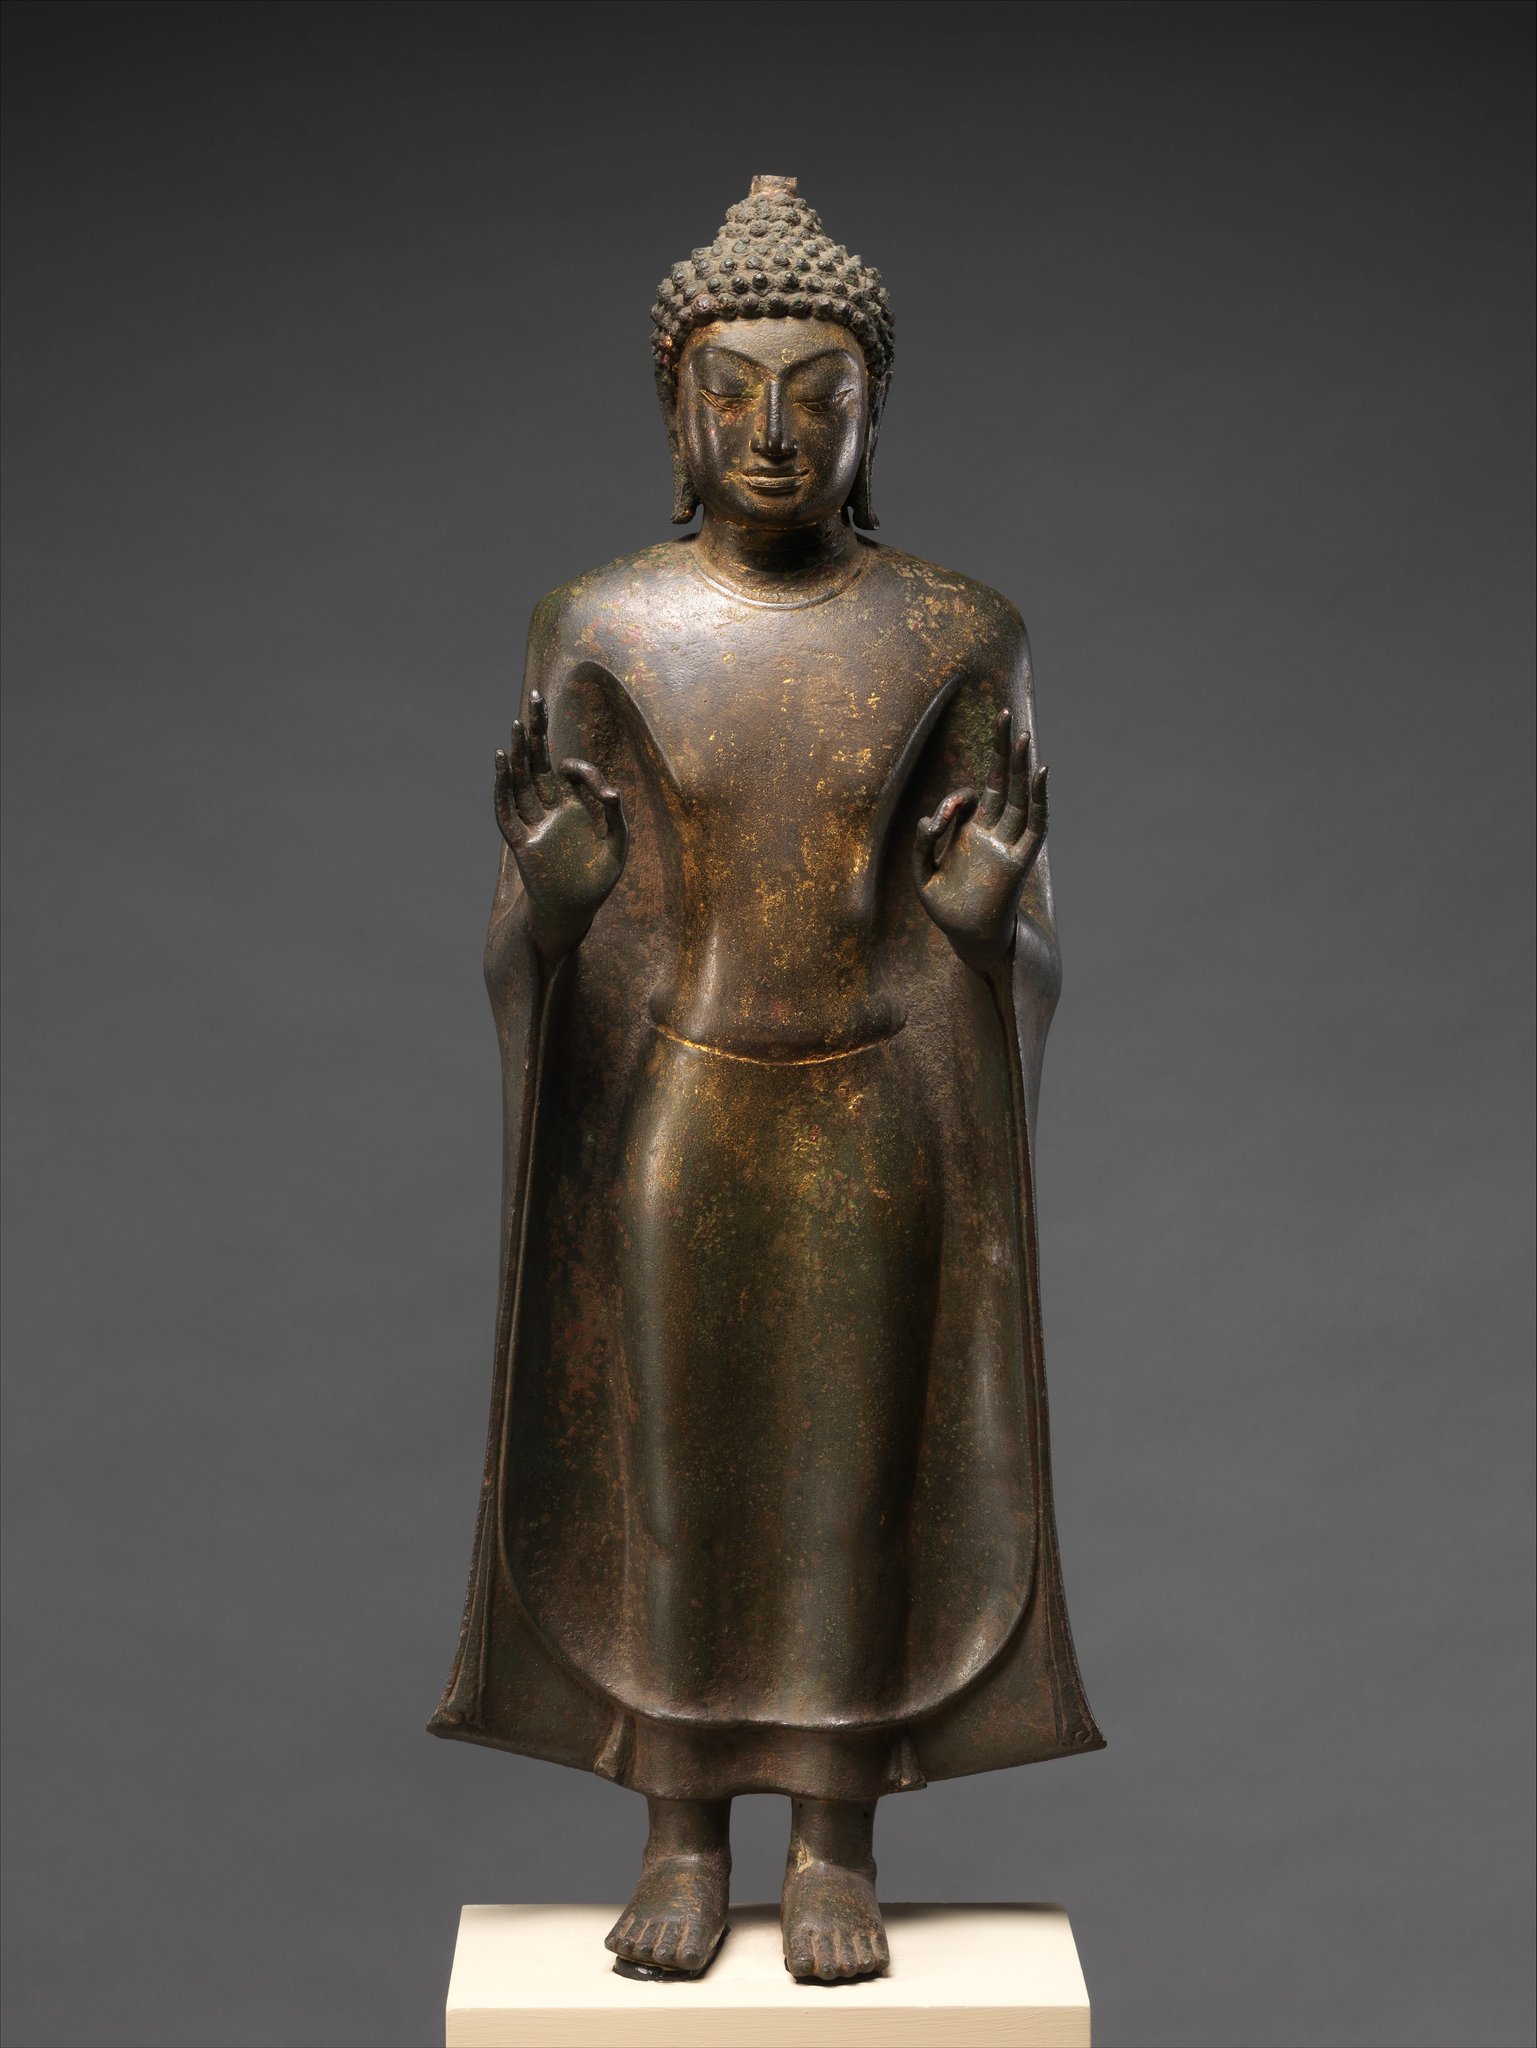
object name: figure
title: Standing Buddha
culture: thai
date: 701-900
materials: bronze, gilt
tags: buddha